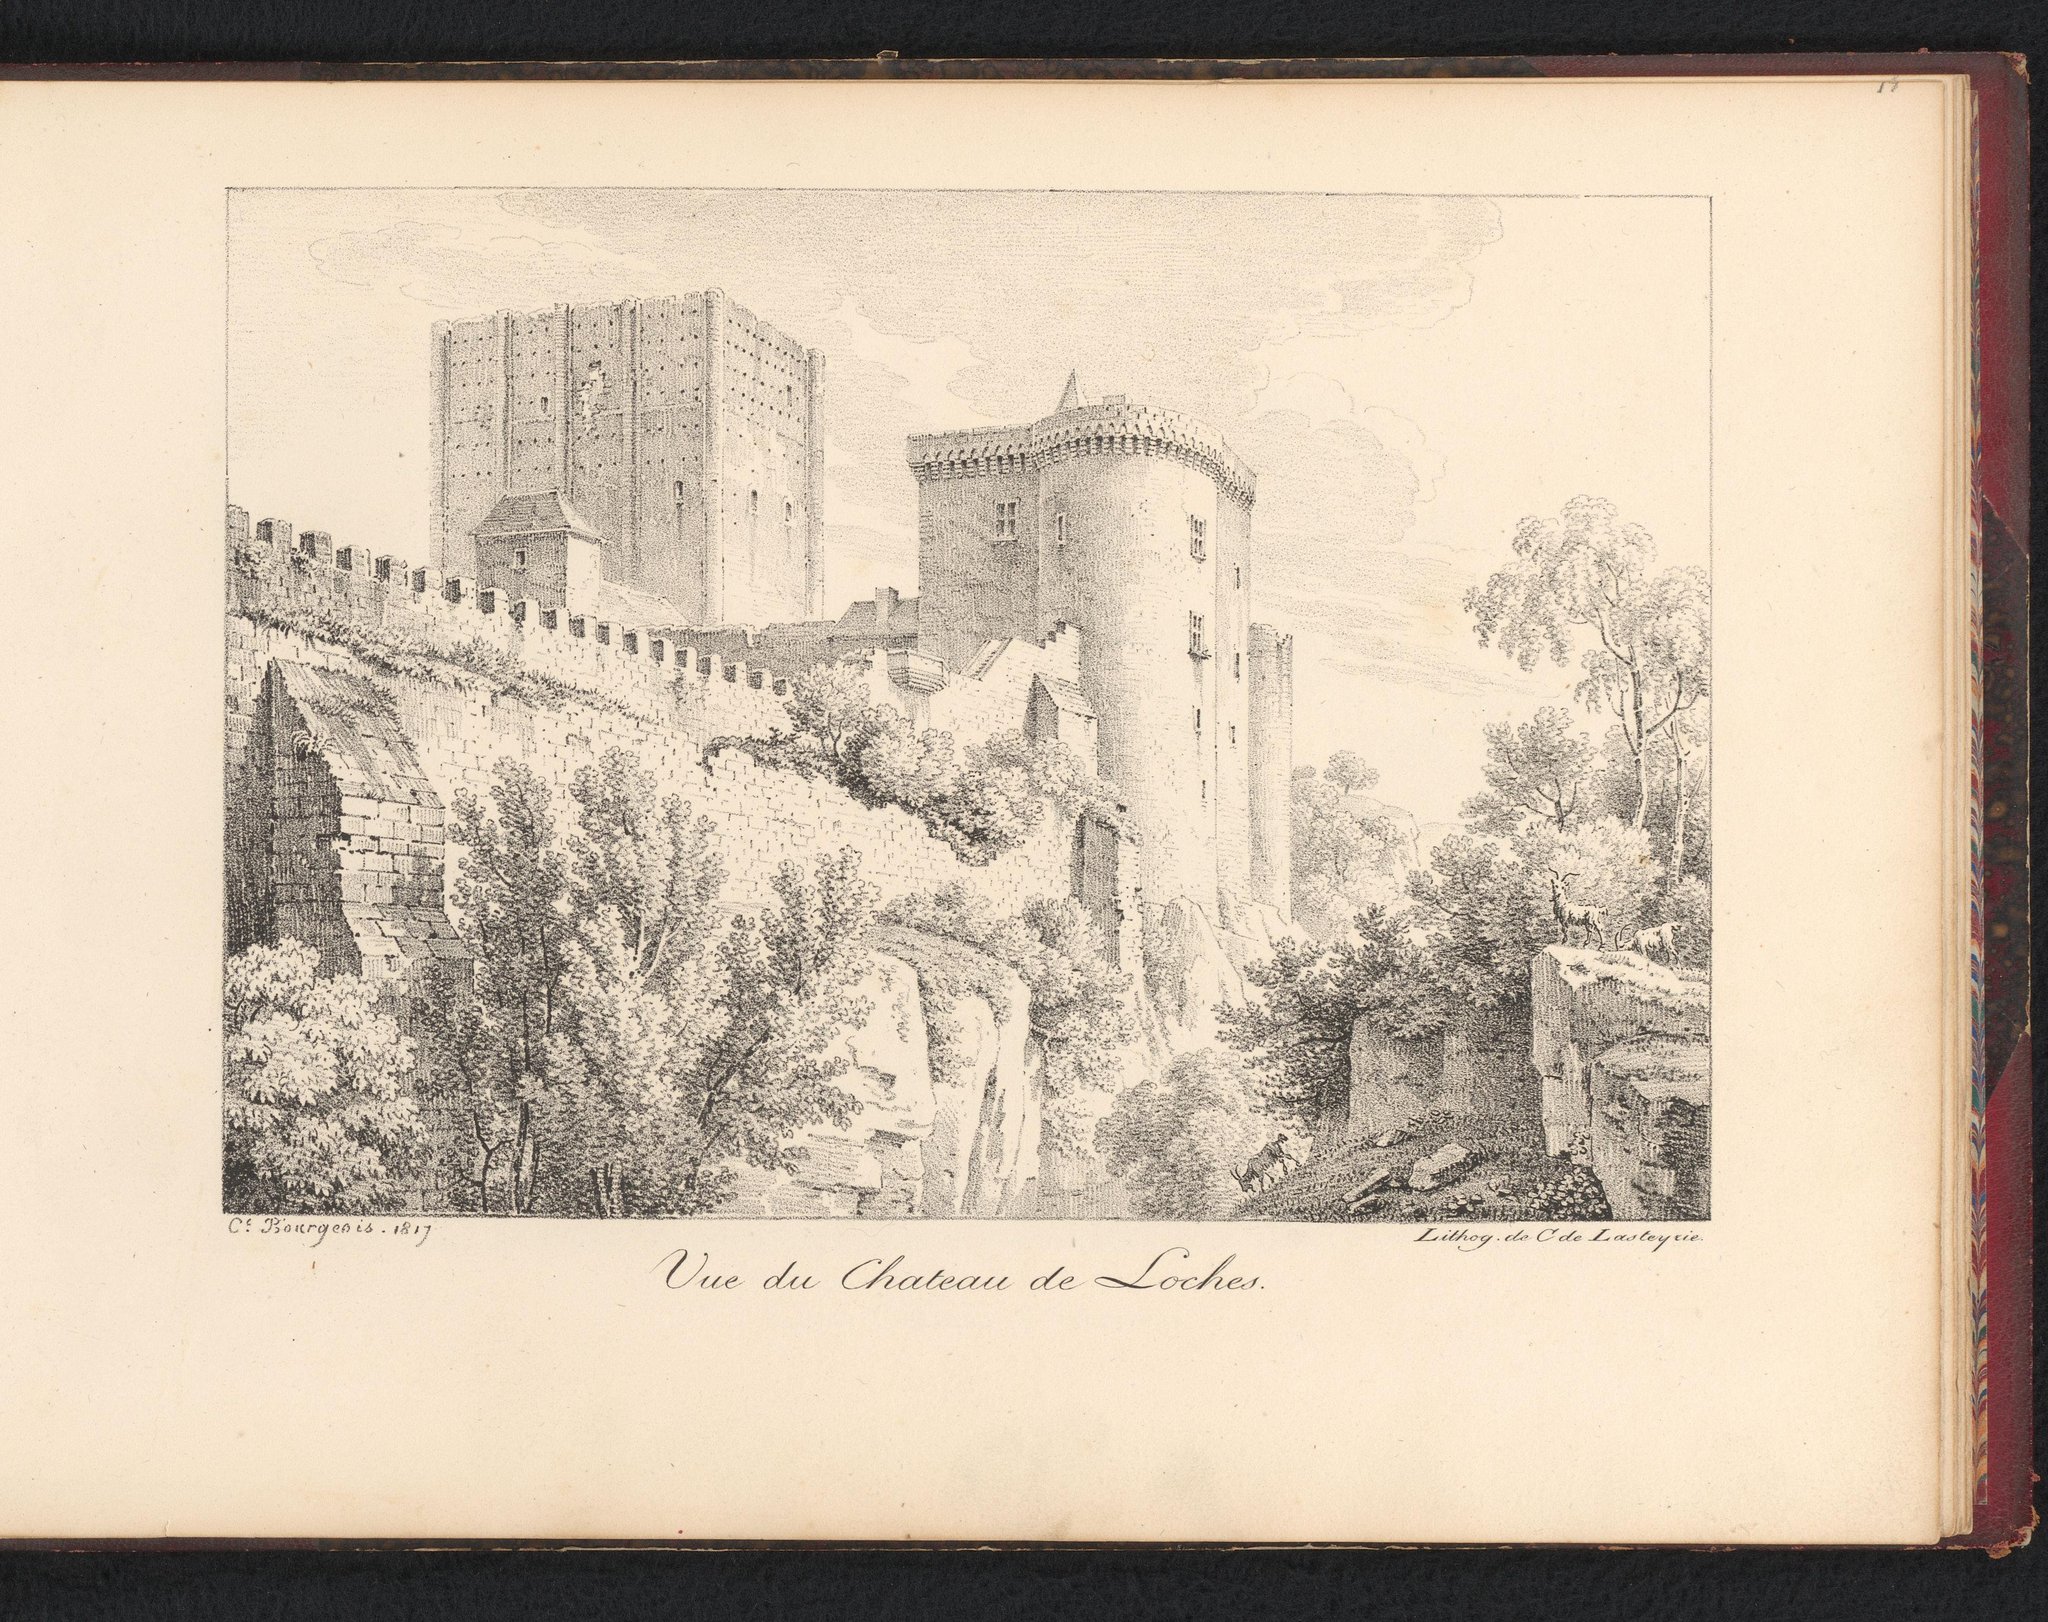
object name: print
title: Vue du Chateau de Loches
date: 1817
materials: paper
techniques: lithograph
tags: landscape with tower or castle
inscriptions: collector's mark: Lugt 2760, collector's mark: Lugt 2228